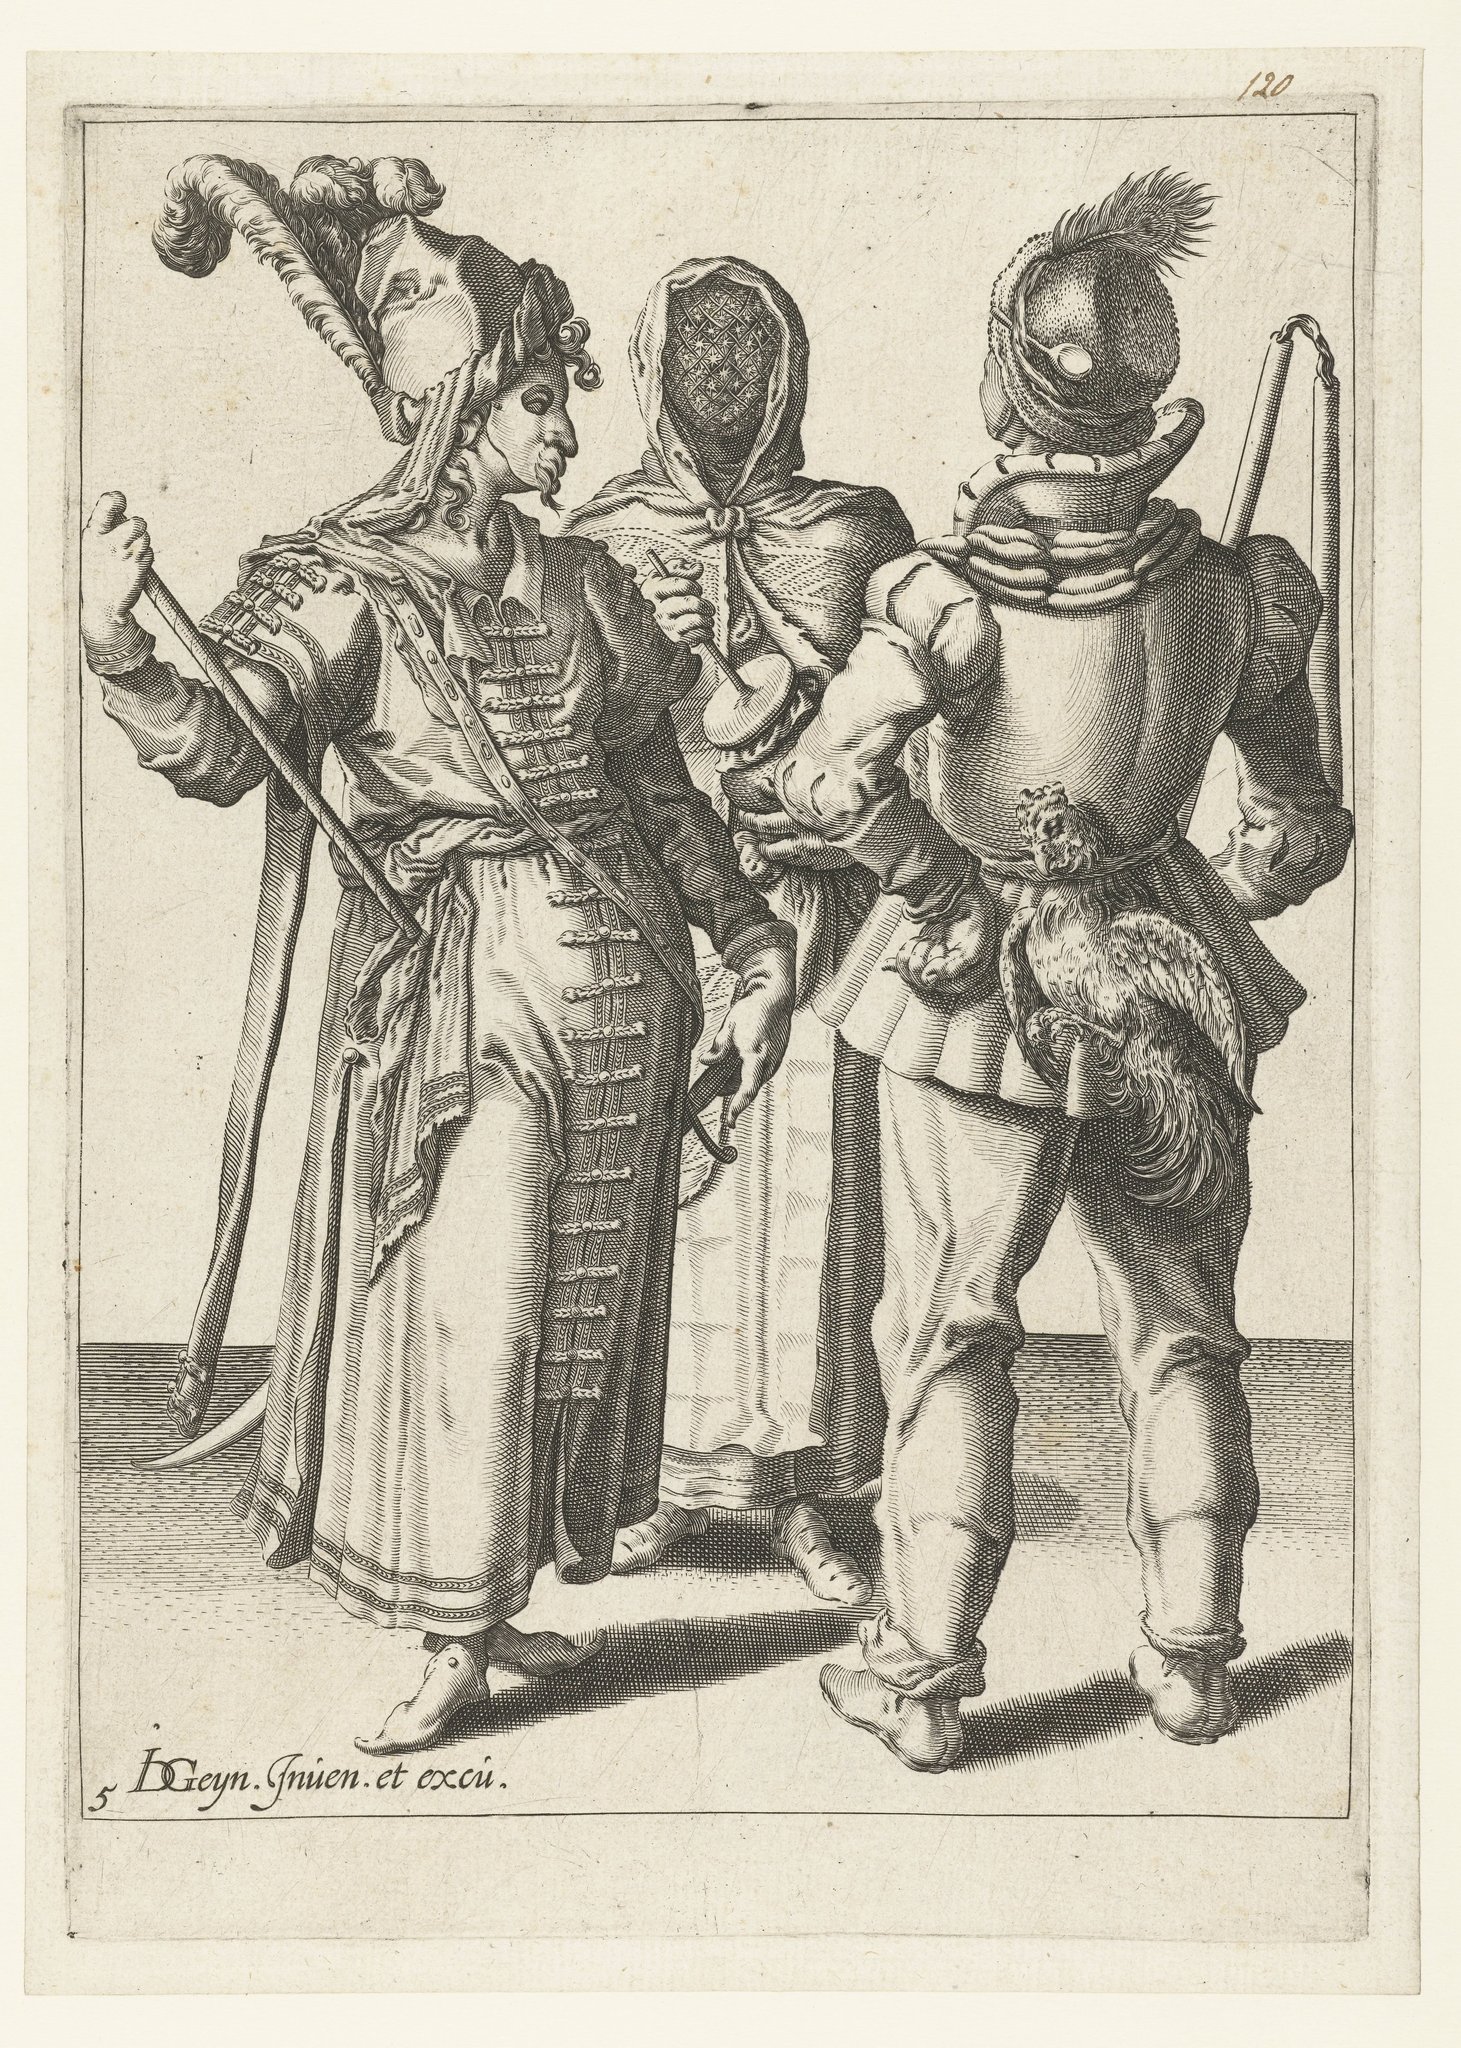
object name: print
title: De maskerades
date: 1595-1596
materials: paper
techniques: engraving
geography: netherlands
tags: mask, masquerade, masked ball, fowl (cock, hen, chicken, etc.), one person playing an instrument, veil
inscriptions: collector's mark: Lugt 2228a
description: Twee gemaskerde en verklede mannen - één op de rug gezien met een haan aan zijn riem, één in oosterse kledij - staan voor een gesluierde dame met een rommelpot in de handen. Deze prent is onderdeel van een serie van tien genummerde prenten: een titelprent en negen prenten waarop twee of drie gemaskerde en/of verklede figuren ten voeten uit zijn weergegeven.